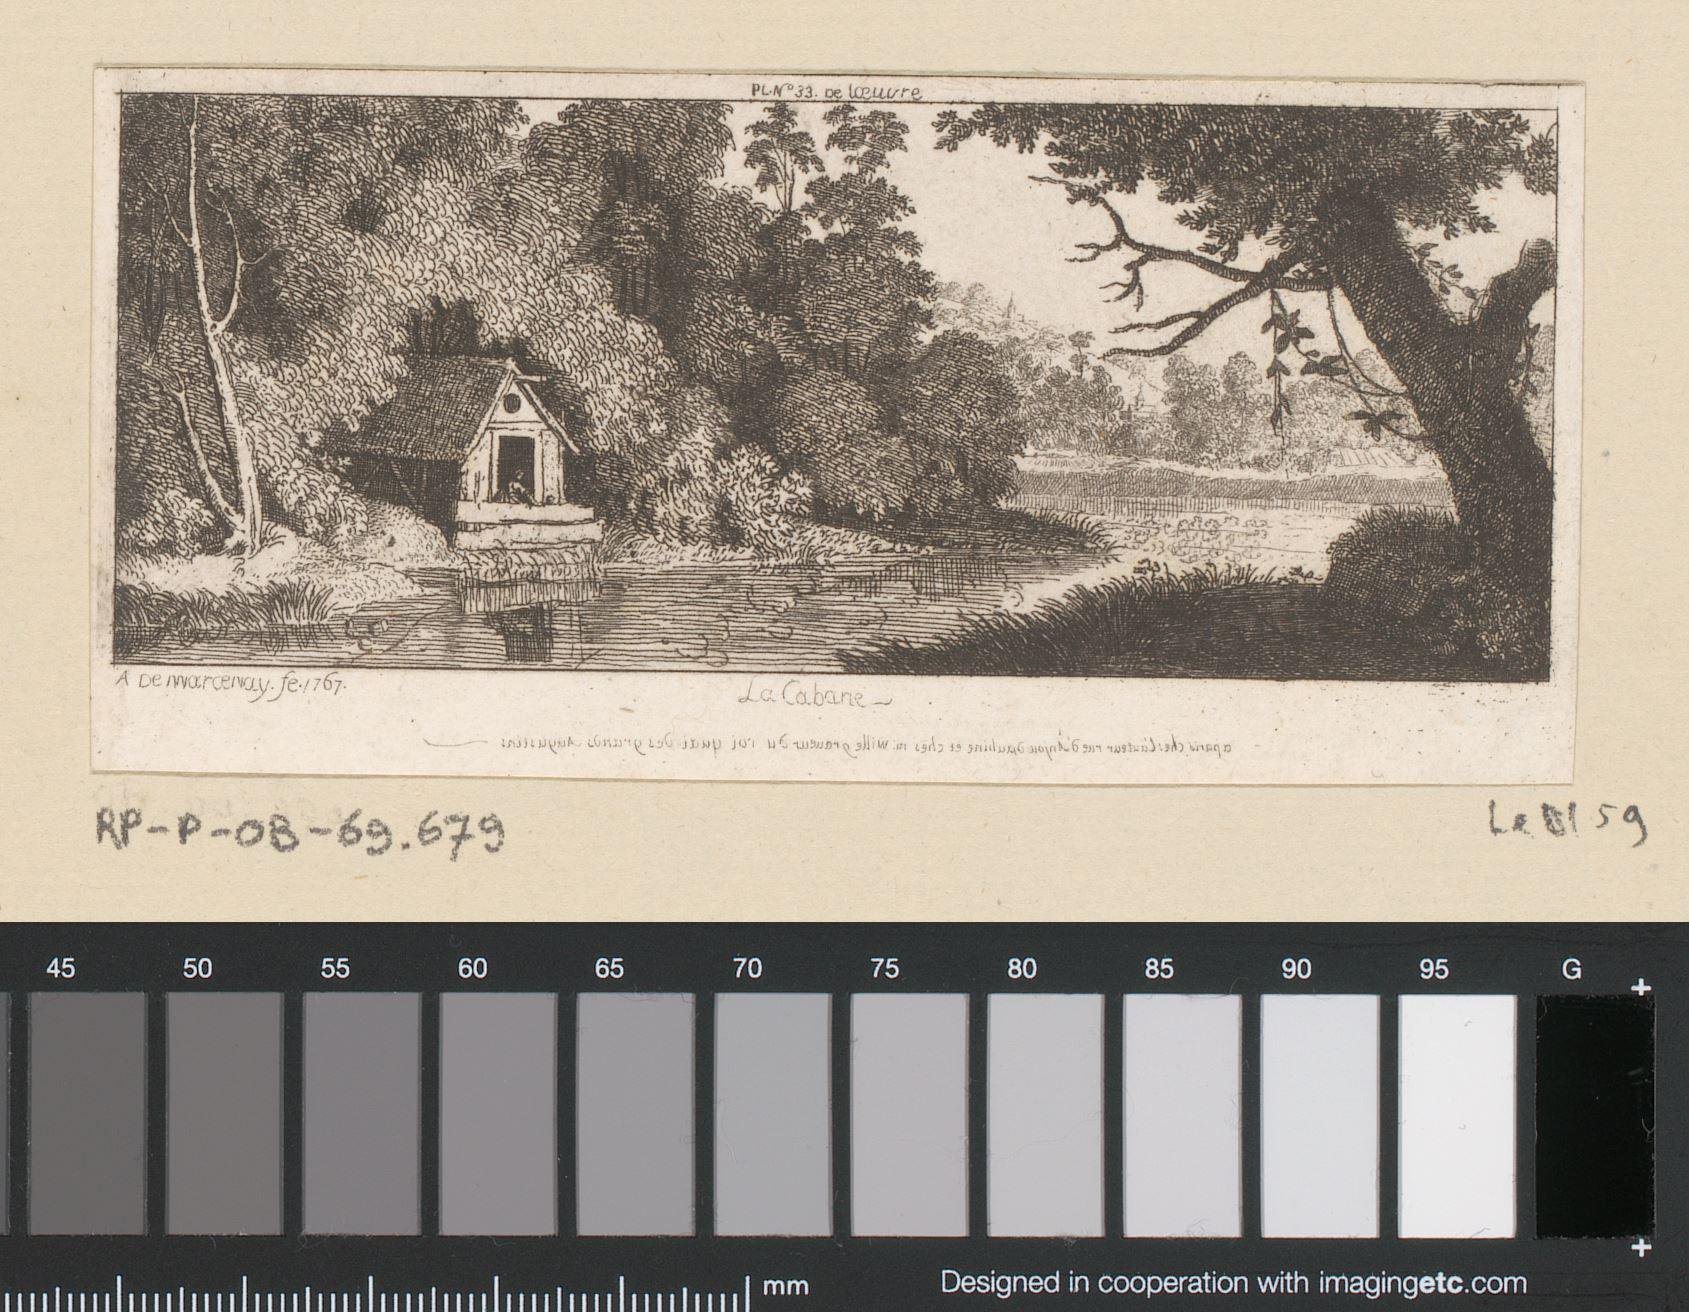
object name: print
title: Gezicht op een huis in het bos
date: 1767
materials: paper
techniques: etching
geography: paris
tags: forest, wood, cottage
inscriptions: collector's mark: Lugt 2228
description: Genummerd midden boven: Pl. No. 33 De L'Oeuvre.